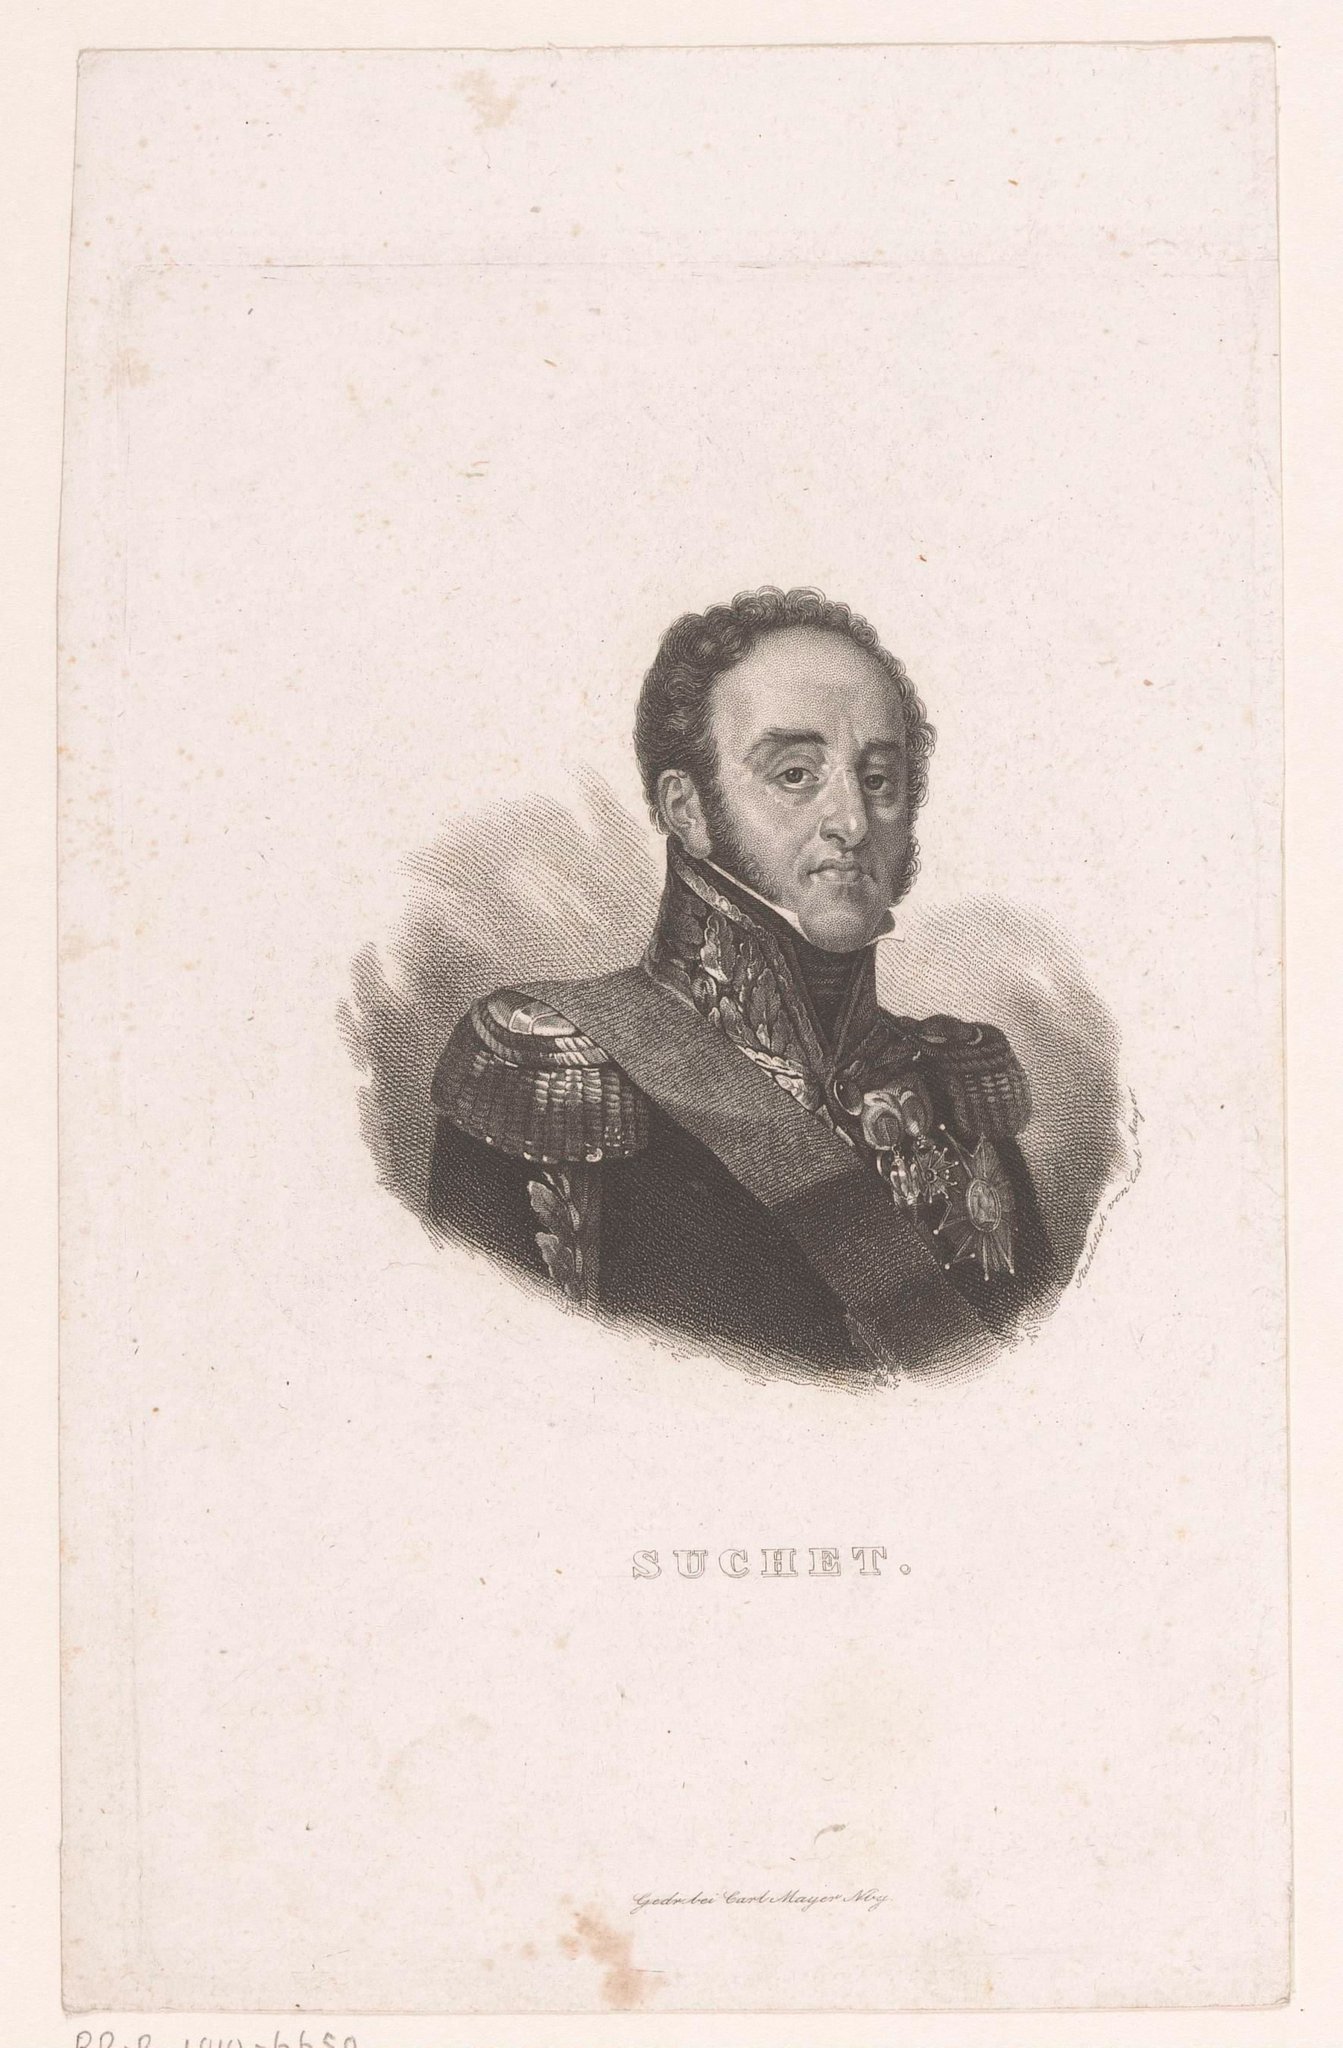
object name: print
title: Portret van Louis-Gabriel Suchet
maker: carl mayer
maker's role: print maker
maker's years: 1798-1868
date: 1808-1868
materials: paper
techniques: engraving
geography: nuremberg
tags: knighthood order, historical persons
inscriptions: collector's mark: Lugt 2228